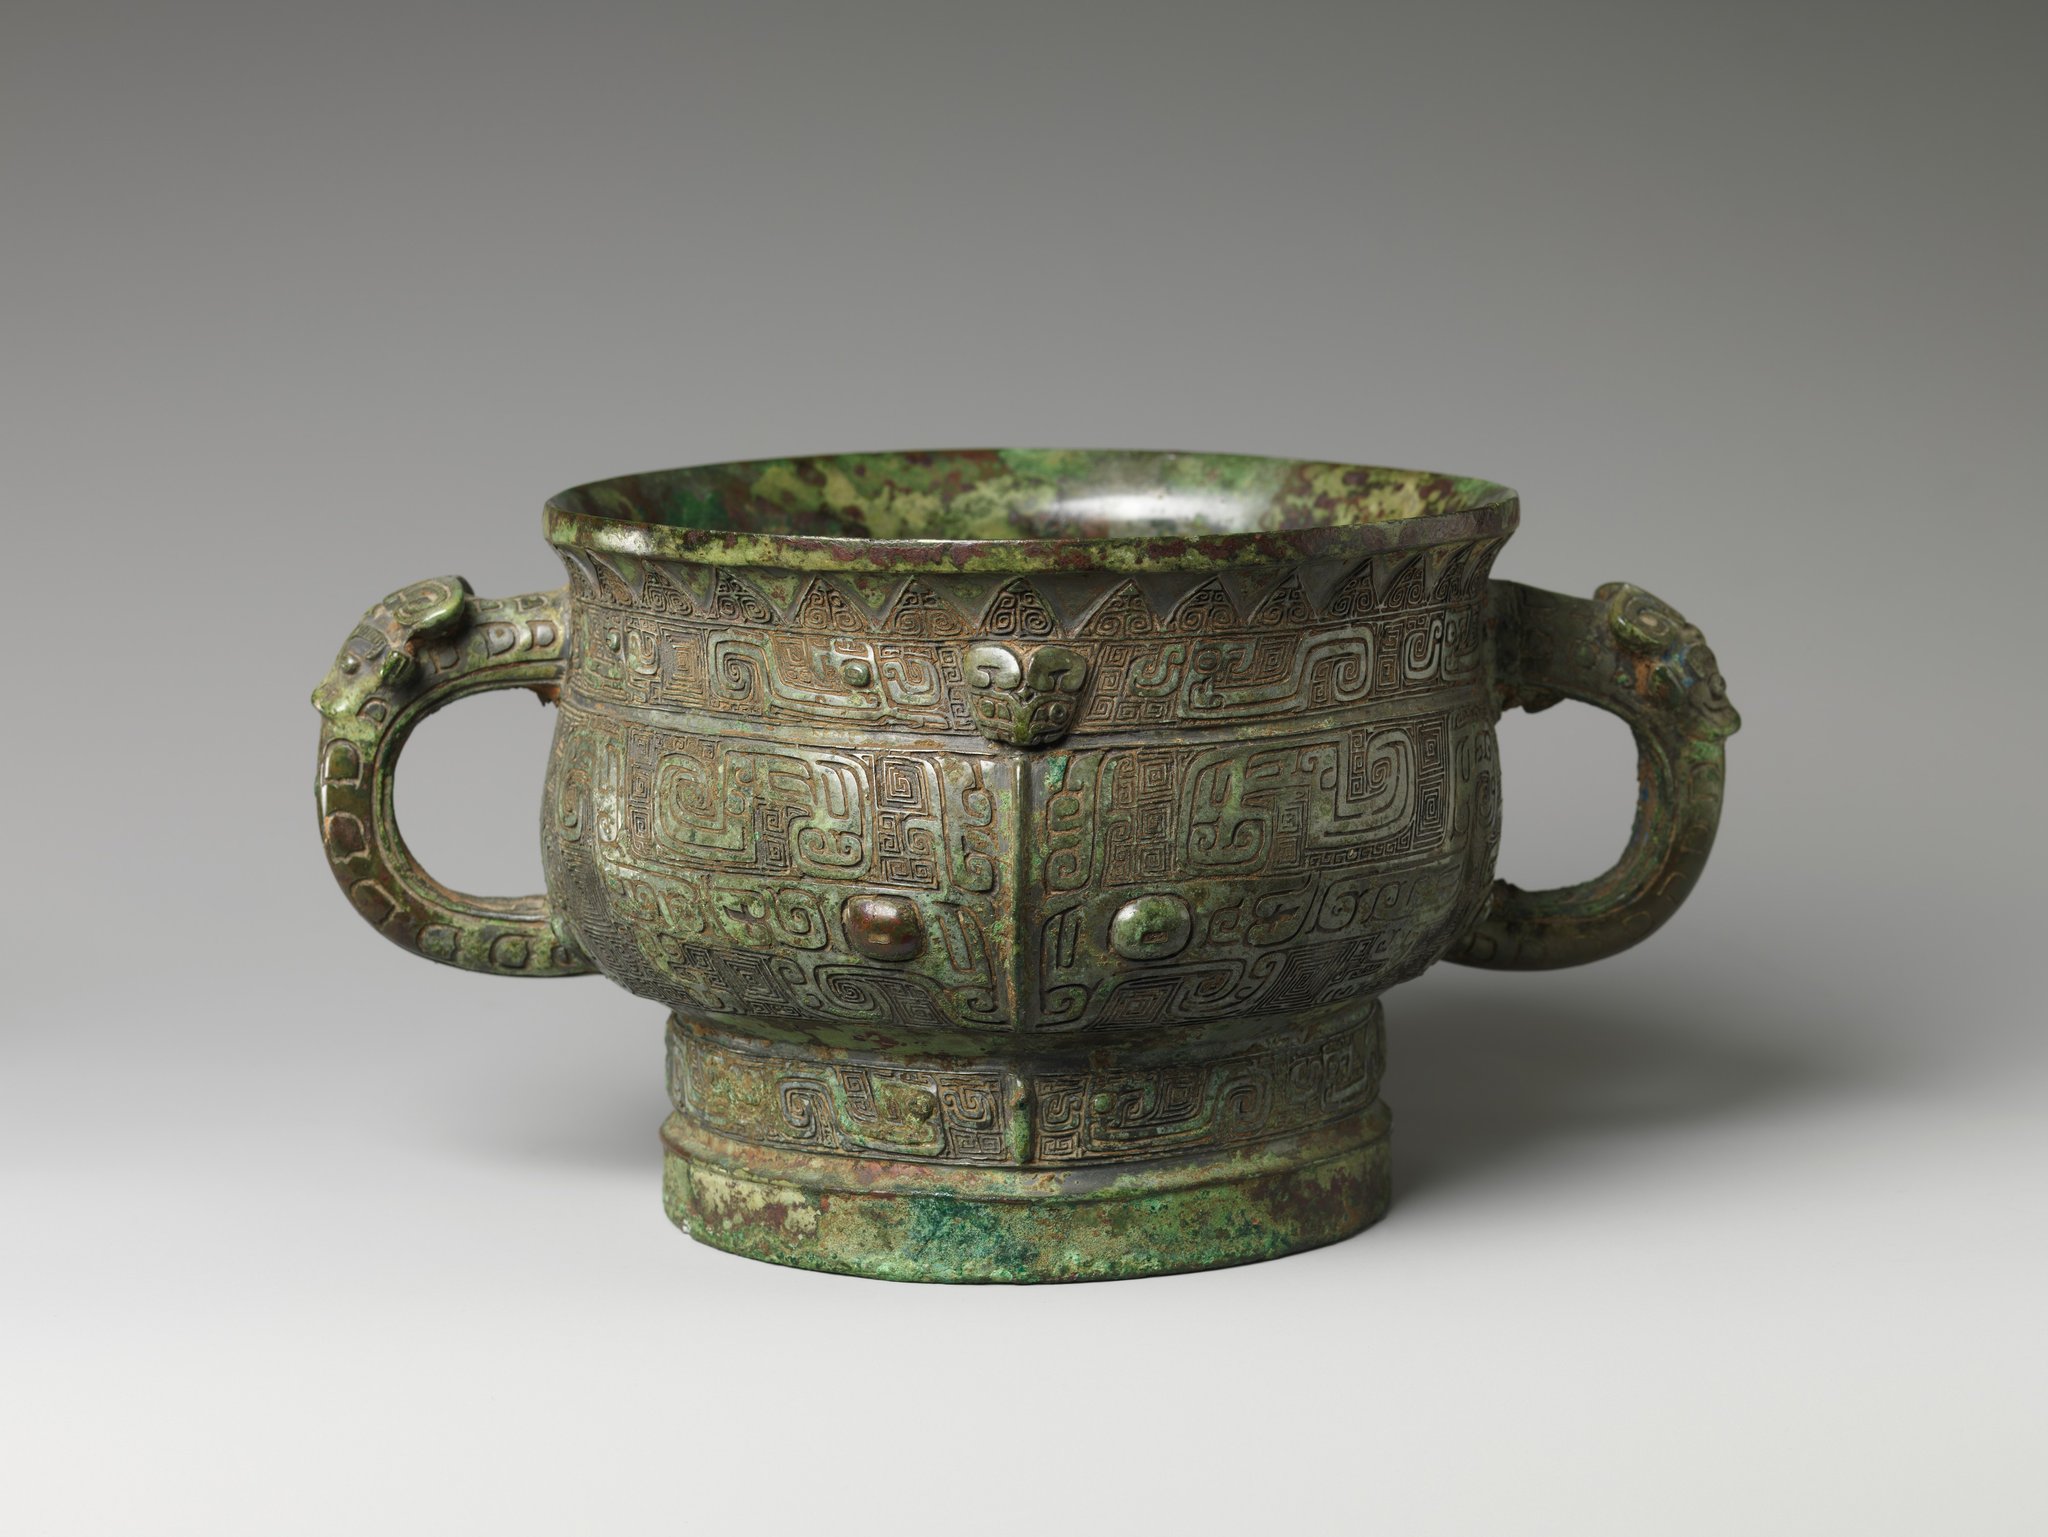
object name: vessel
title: Food Serving Vessel (Gui)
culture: chinese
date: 1200-1101 BCE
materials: bronze